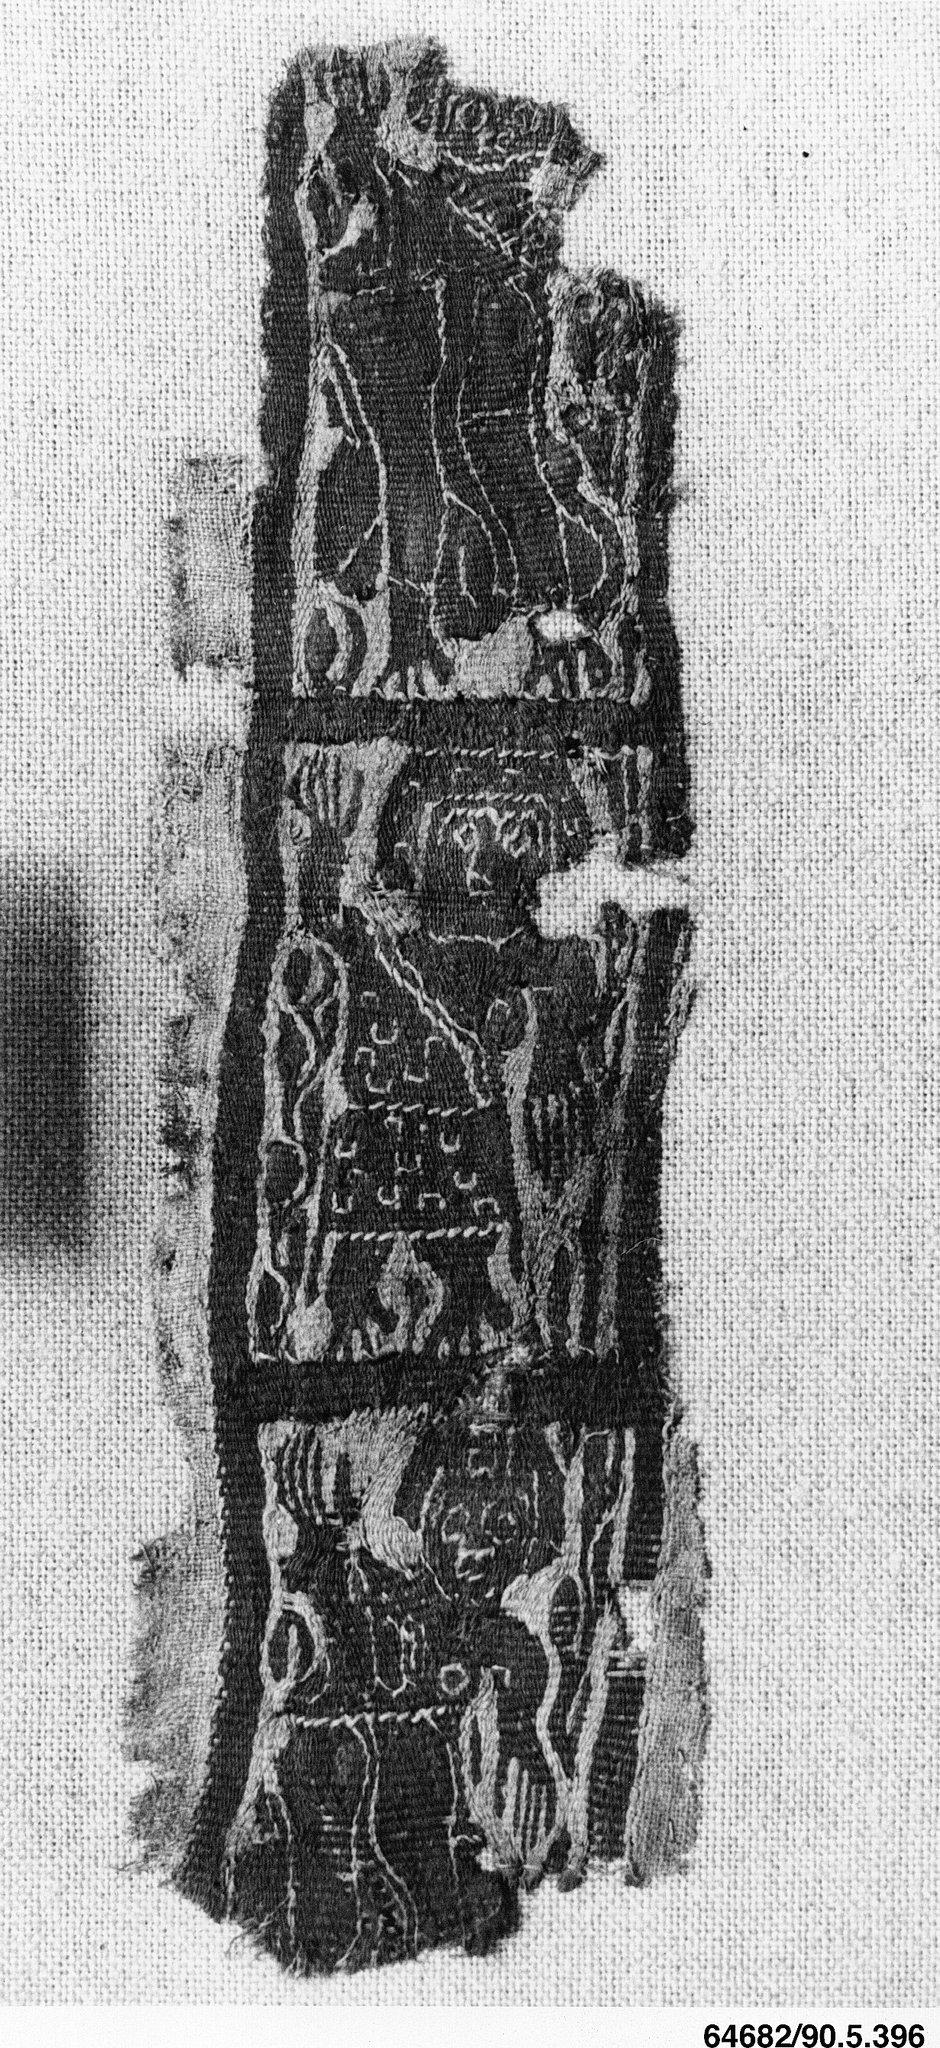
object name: textile fragment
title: Fragment of a Shoulder Band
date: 301-500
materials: linen, wool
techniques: weave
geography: egypt